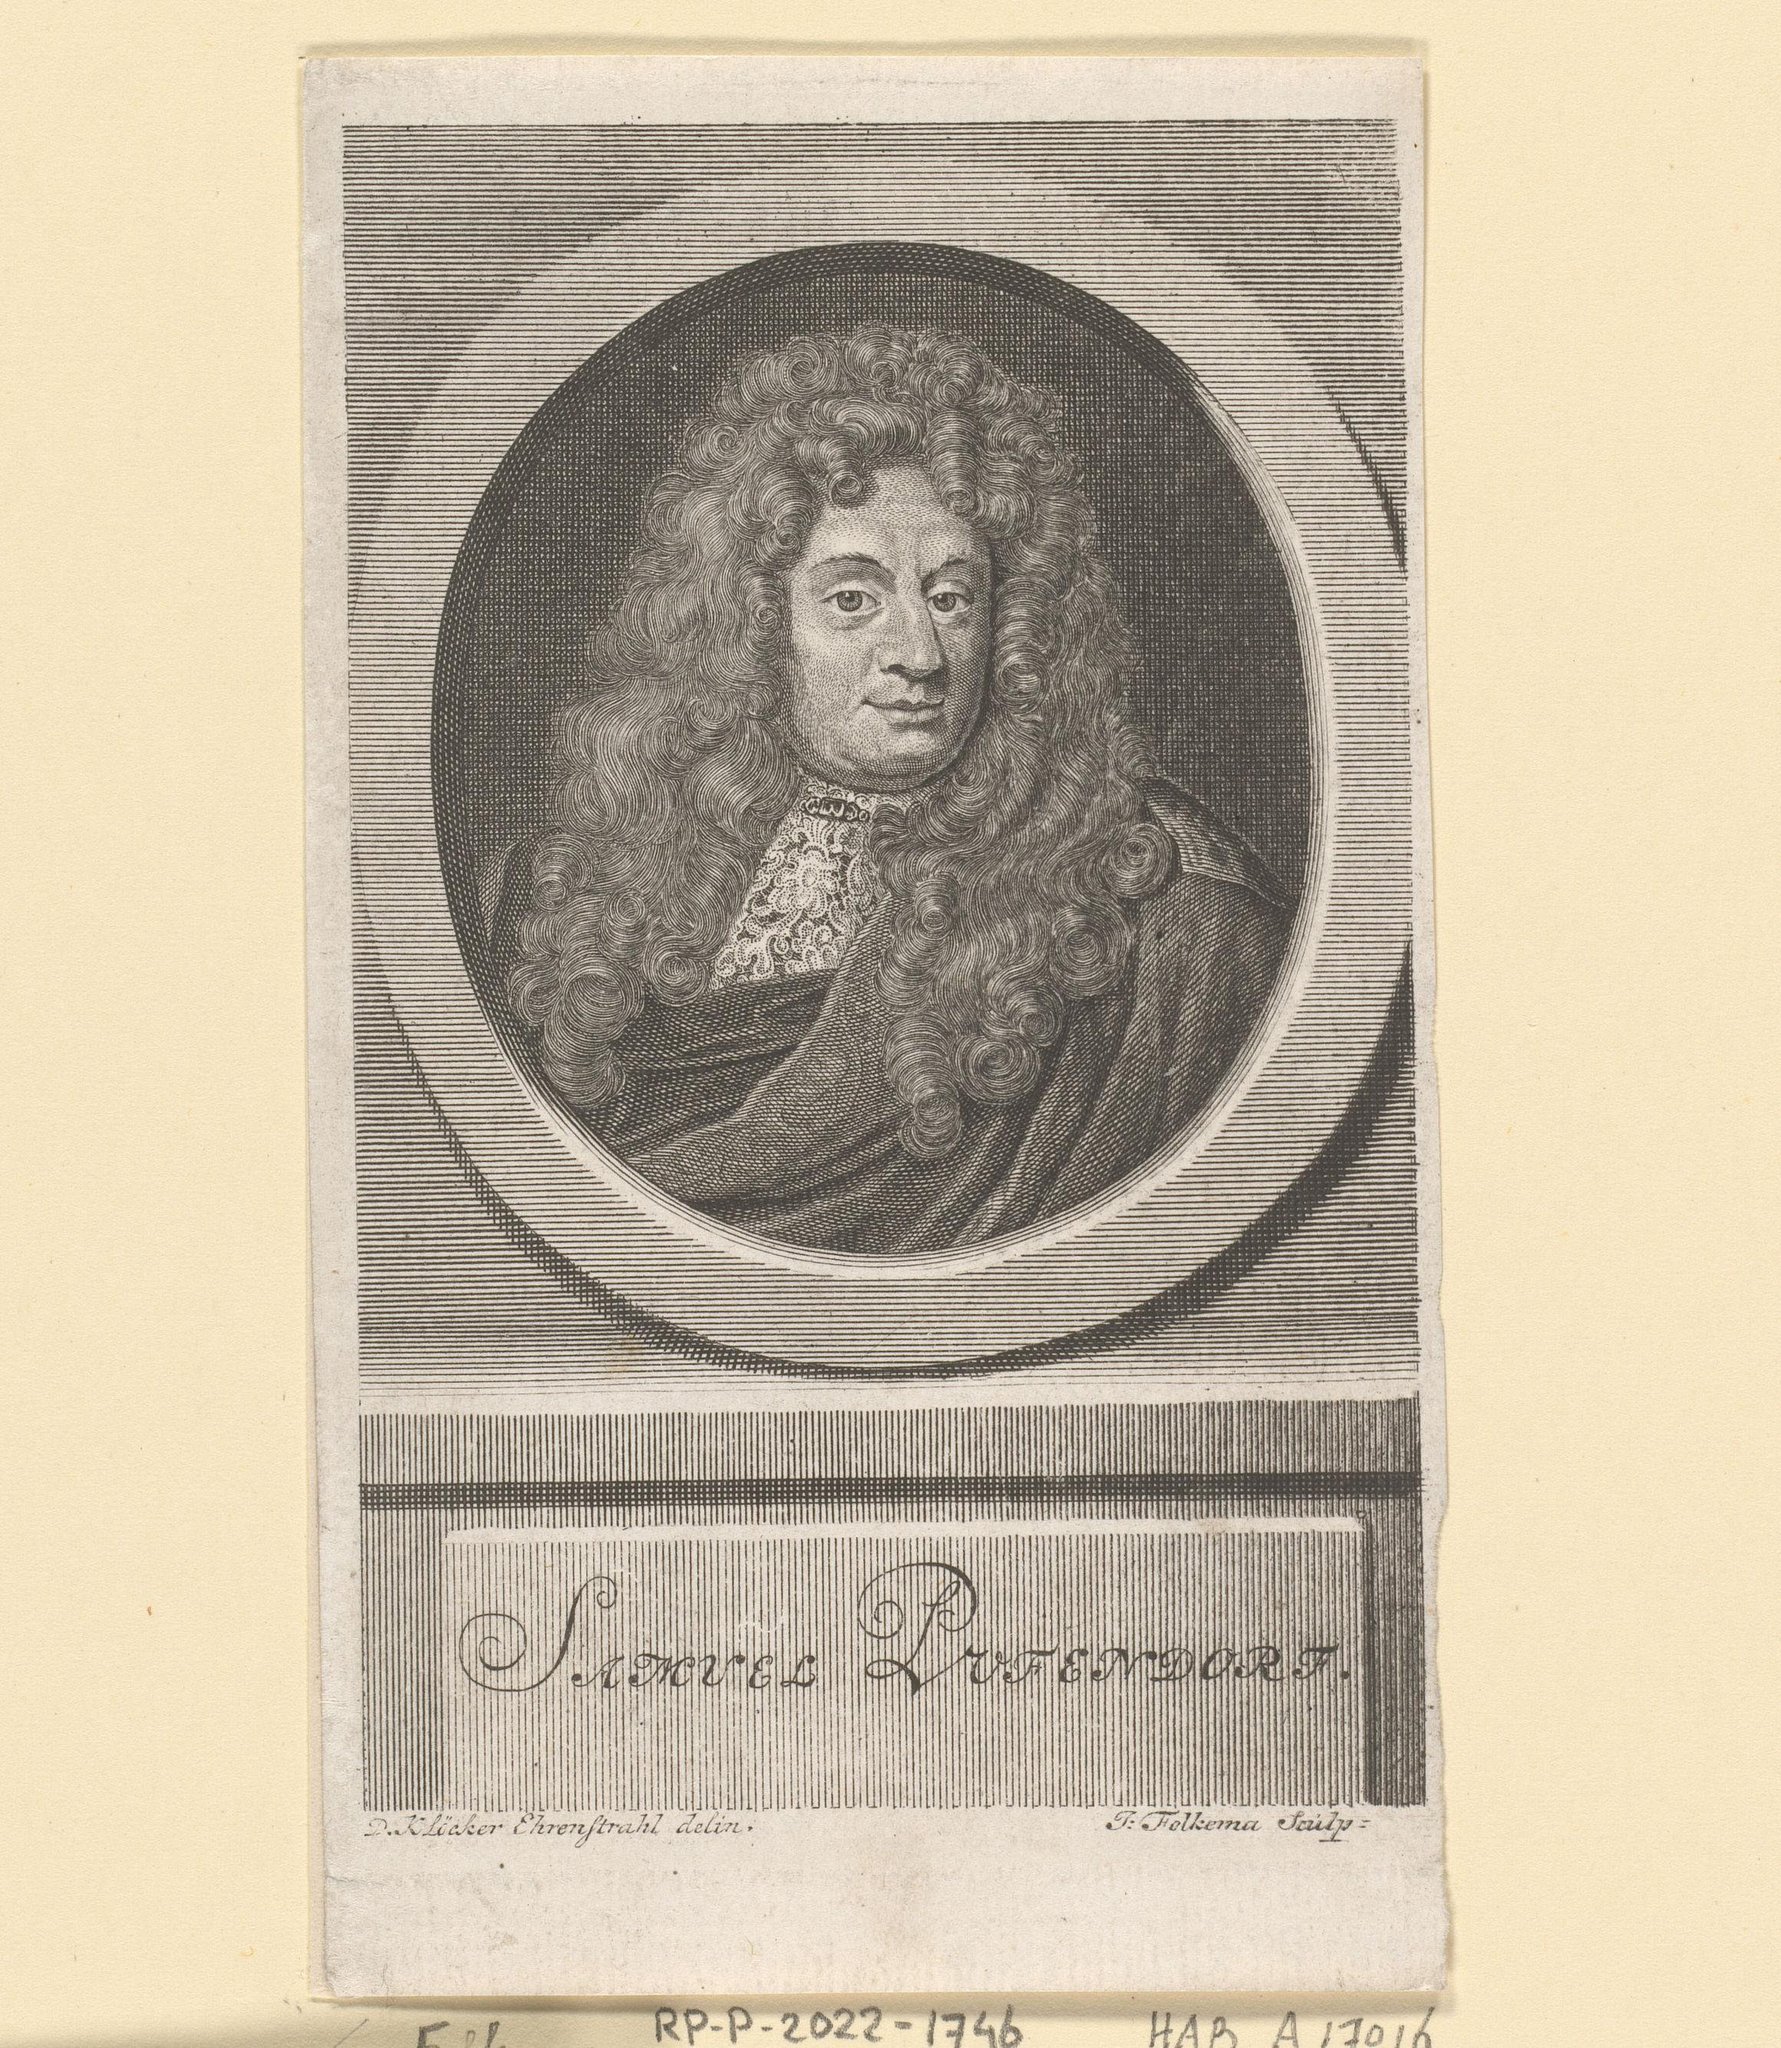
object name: print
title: Portret van Samuel von Pufendorf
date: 1732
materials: paper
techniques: engraving, etching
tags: history and archaeology (+ portrait of scholar, scientist), scholar, philosopher, historical persons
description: Prent waarschijnlijk uit: Pufendorf, Samuel von. Histoire de suede, avant et depuis la fondation de la monarchie. Amsterdam: Zacharie Chatelain, 1732.